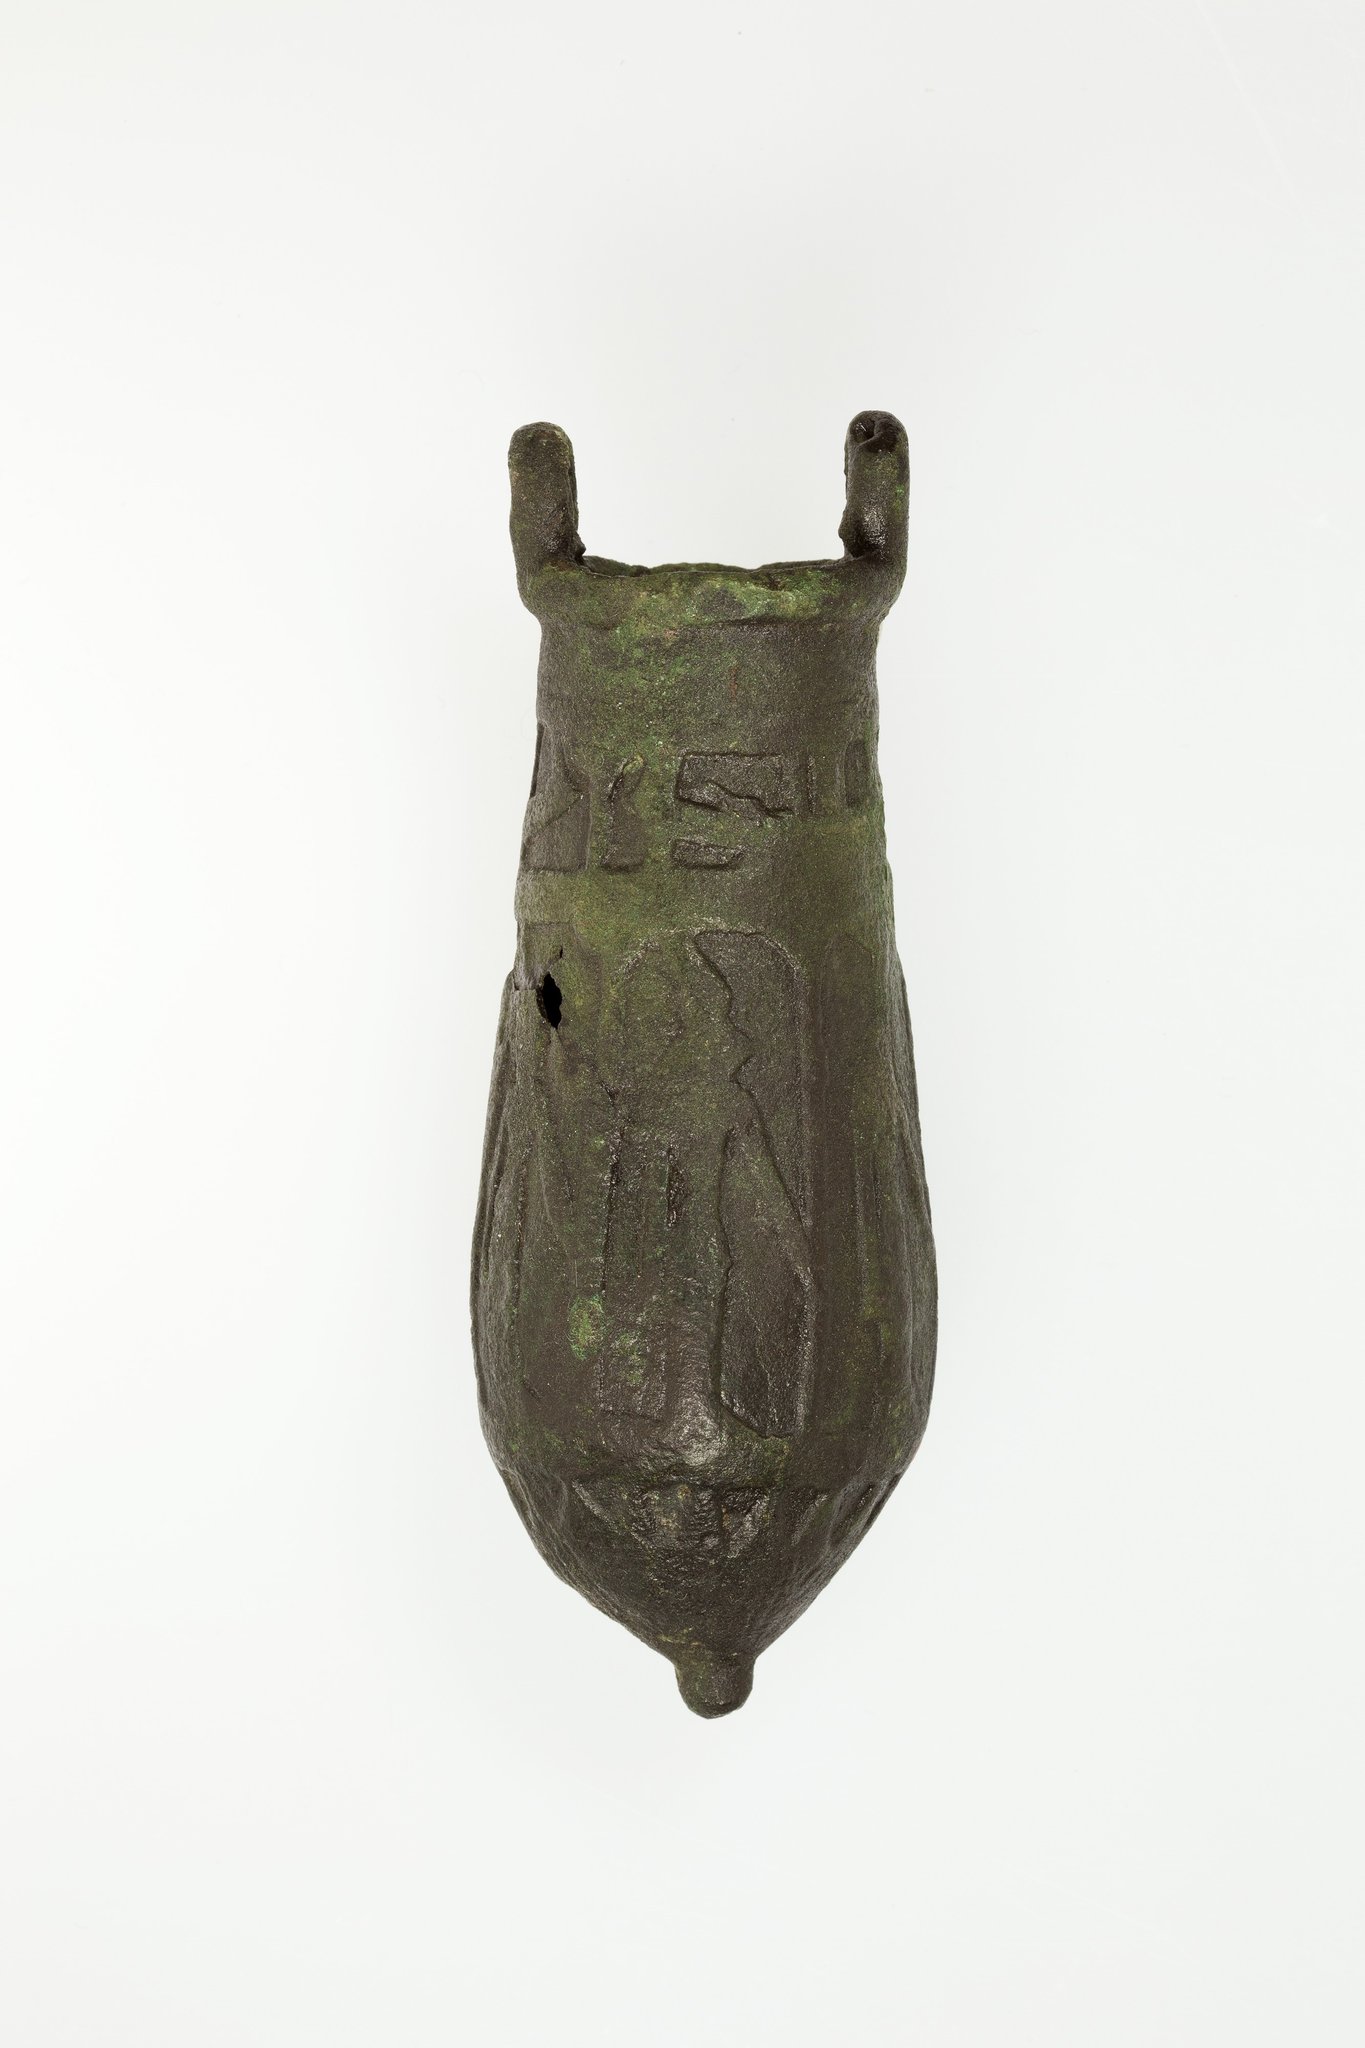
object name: situla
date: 600 BCE-100 CE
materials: copper alloy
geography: egypt